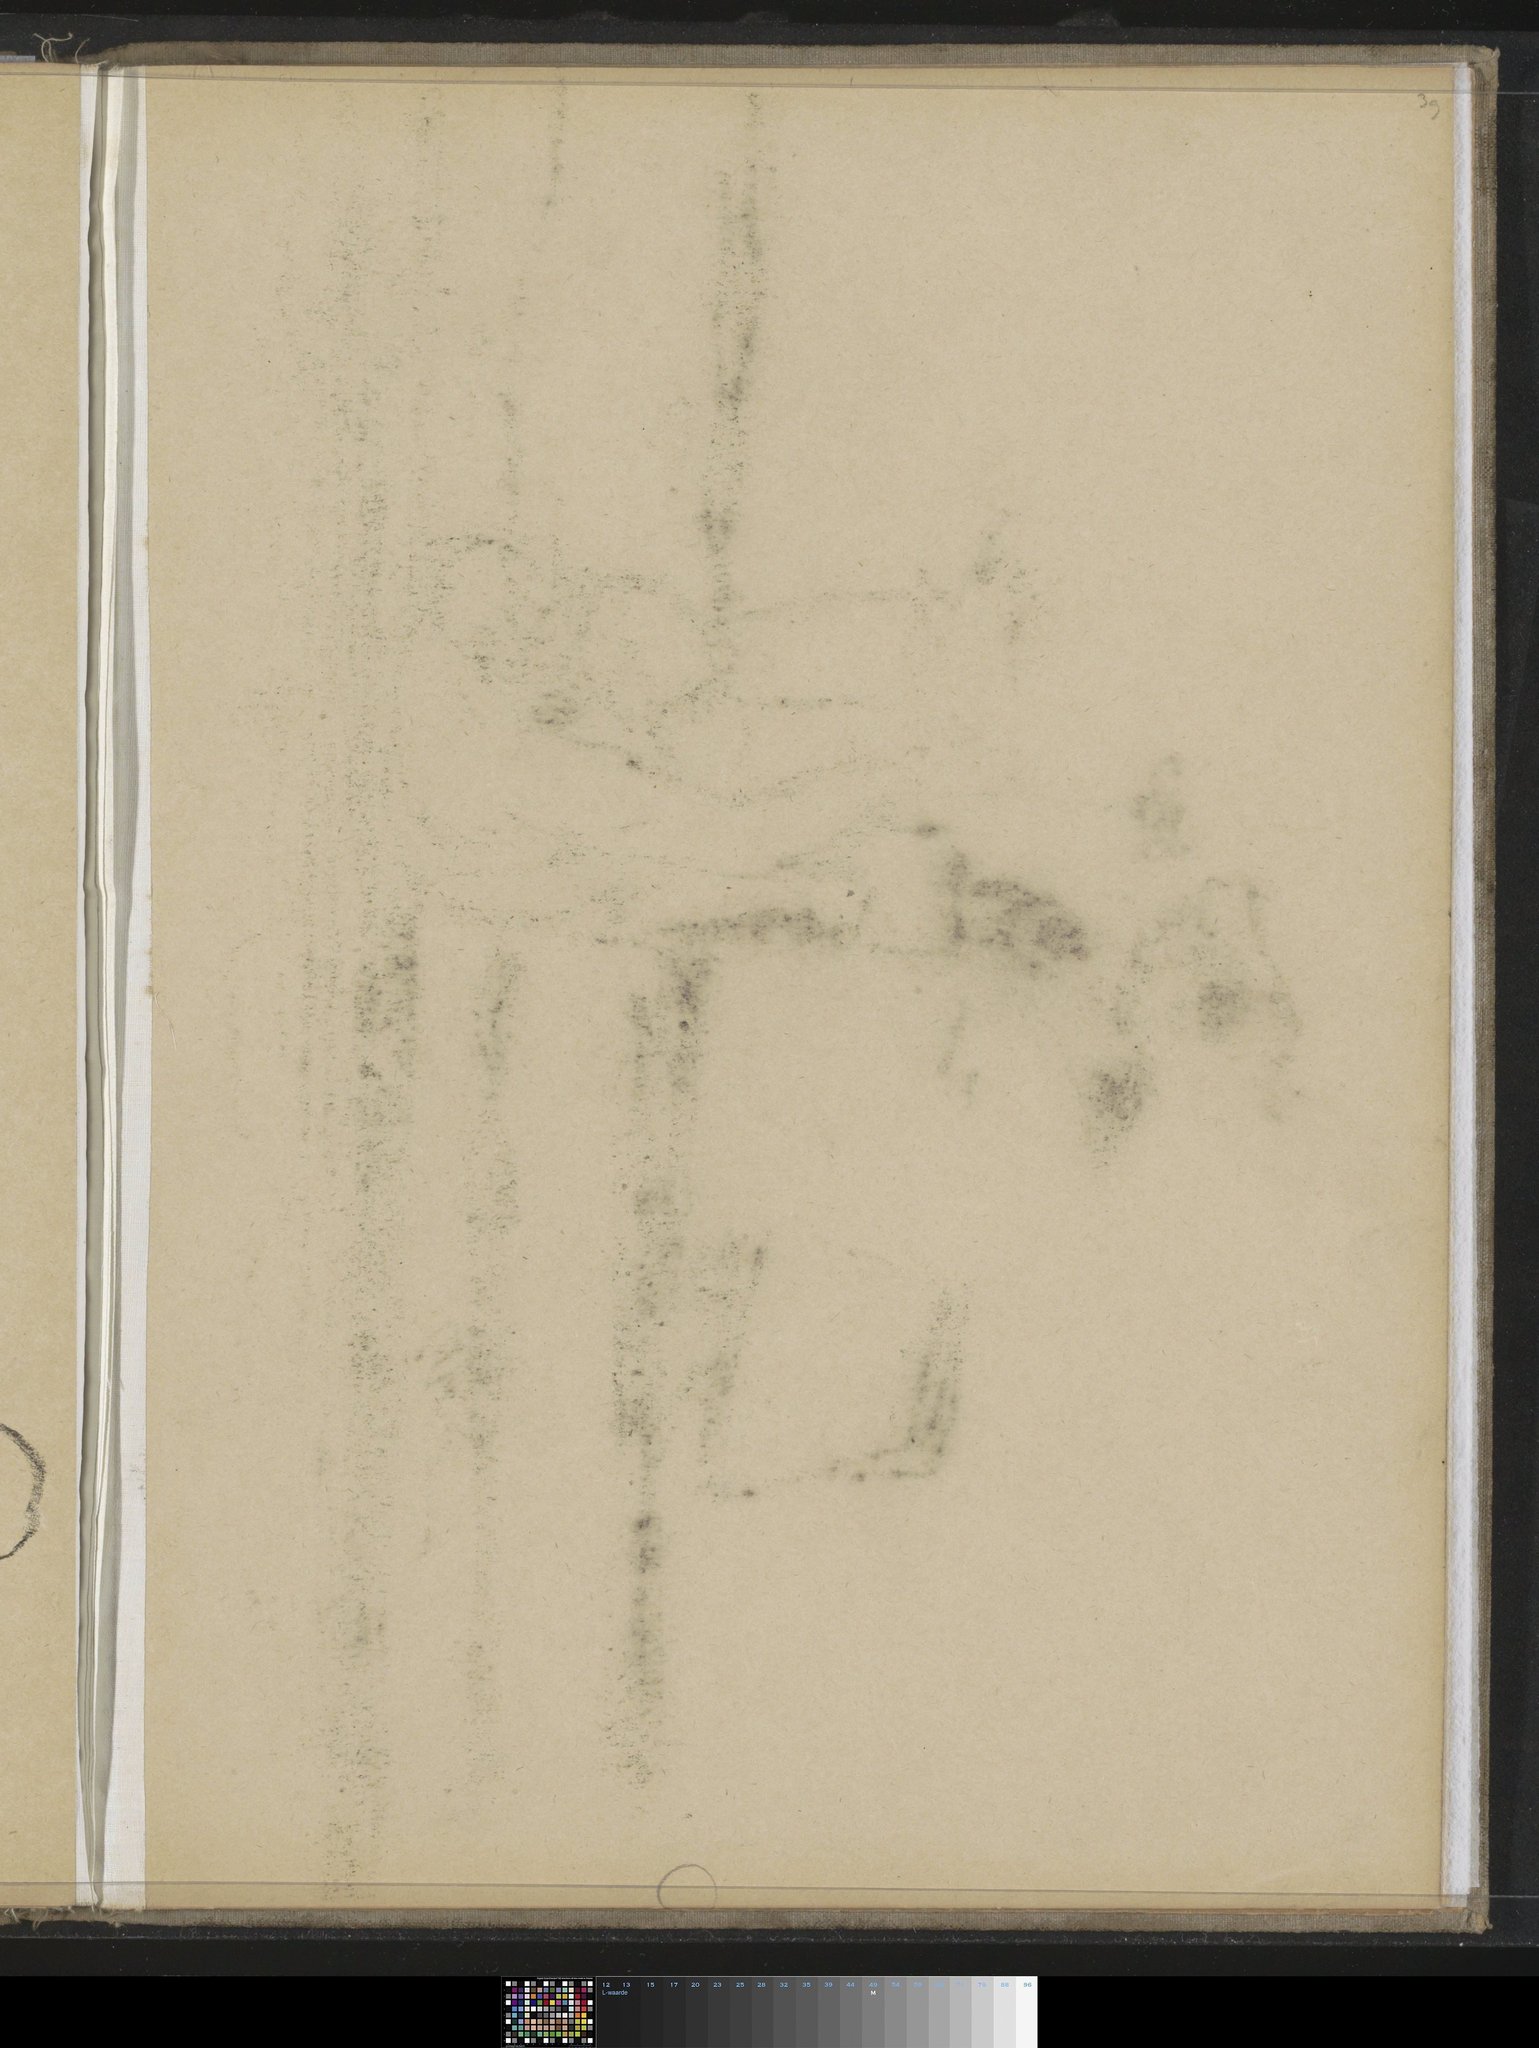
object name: sketchbook leaf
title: Abklatsch van de krijttekening op pagina 38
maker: willem witsen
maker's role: draughtsman, painter, print maker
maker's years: 1860-1923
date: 1893-1897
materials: paper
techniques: printmaking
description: Pagina 39 uit een schetsboek met 25 bladen.